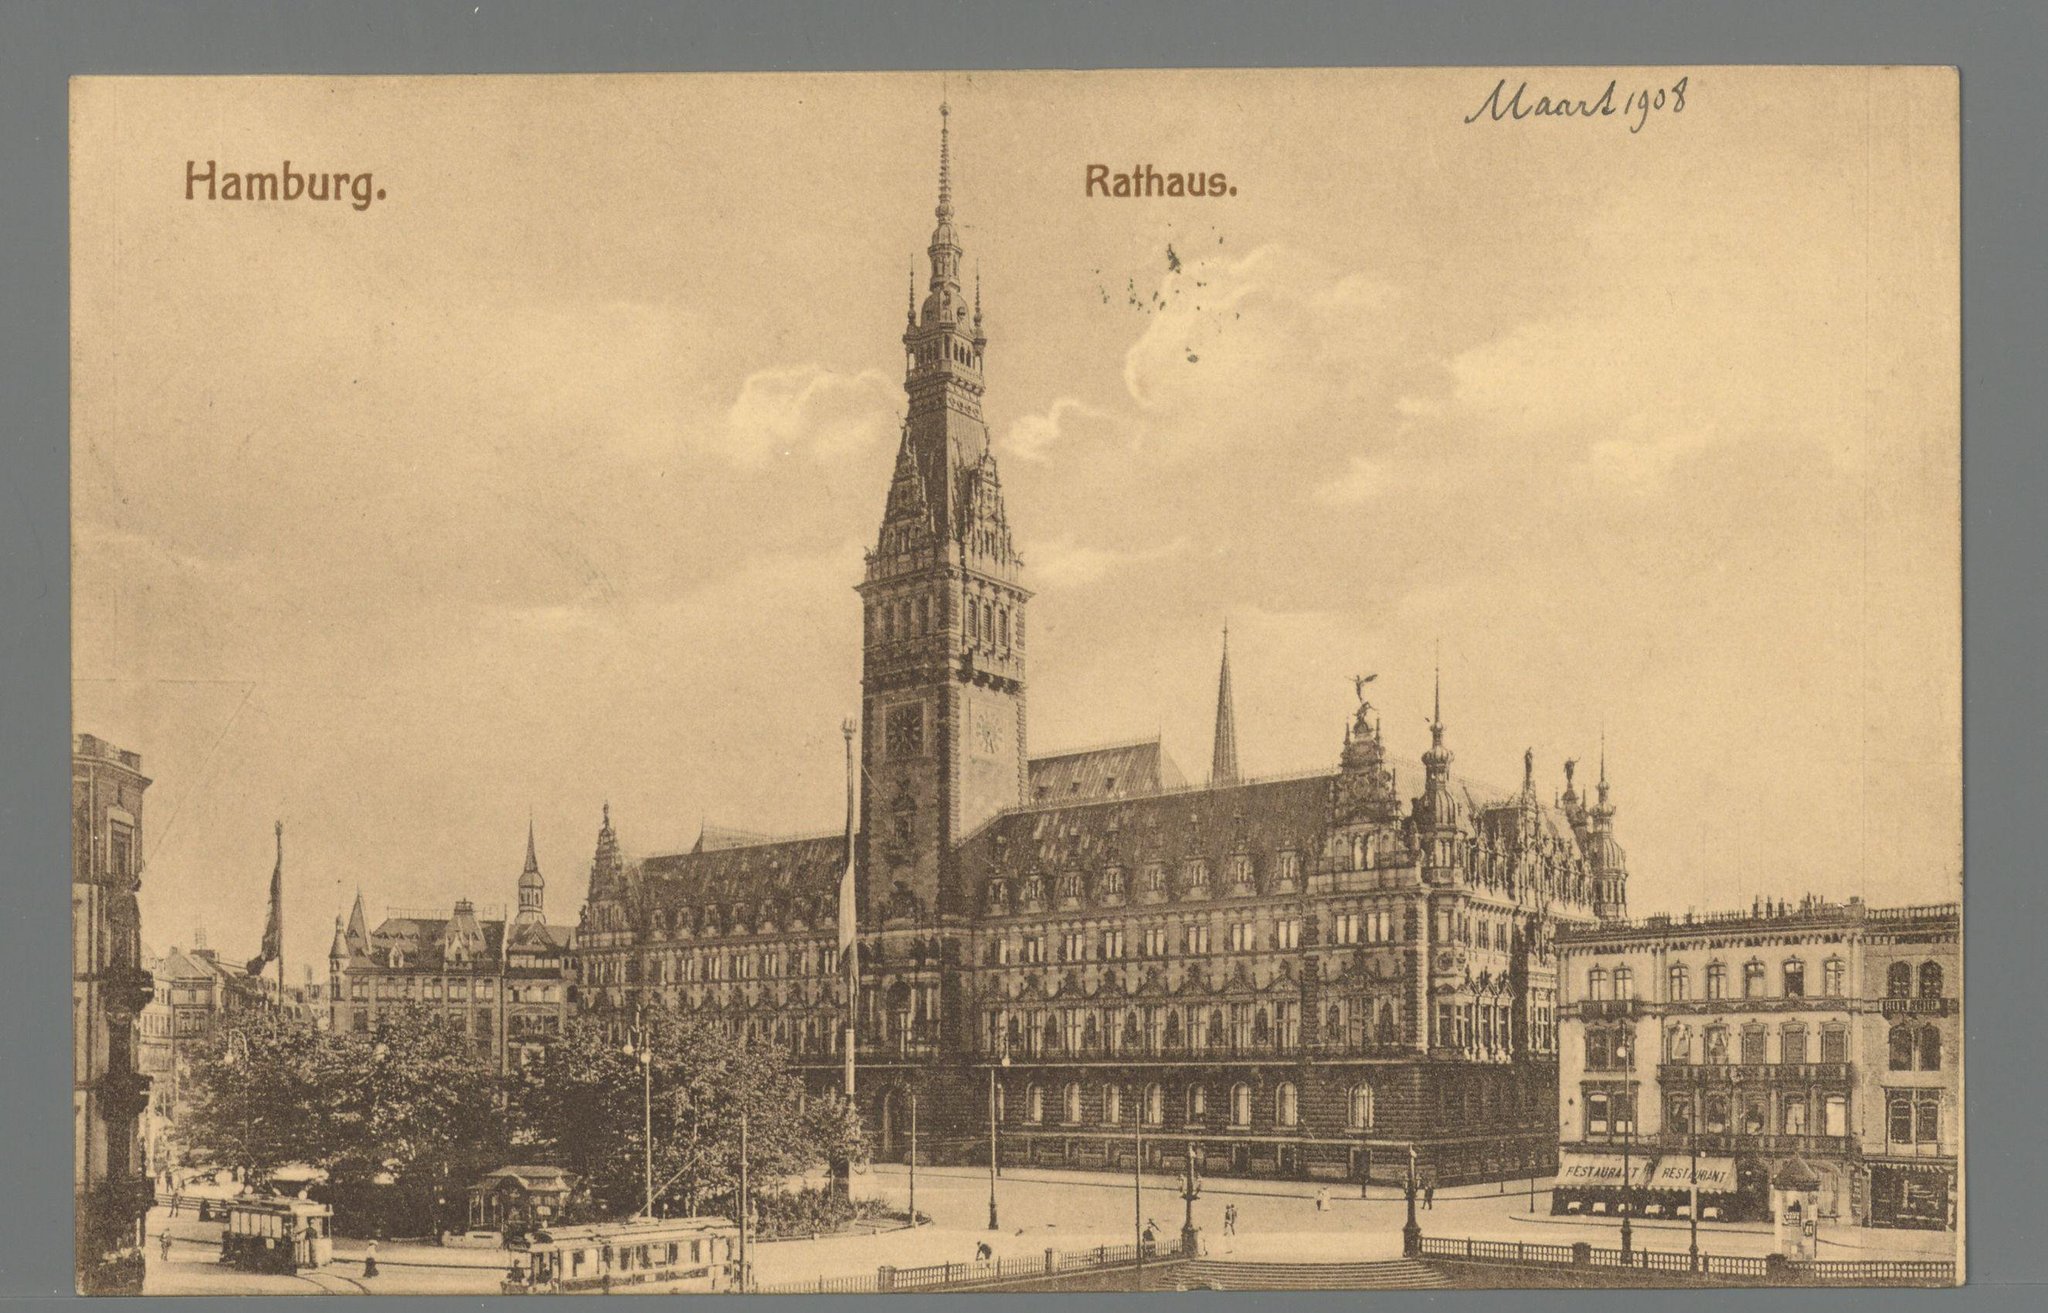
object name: ansichtkaart, prentbriefkaart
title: Hamburg. Rathaus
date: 1905-1908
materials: cardboard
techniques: photograph, writing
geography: hamburg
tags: townhall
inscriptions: postage stamp